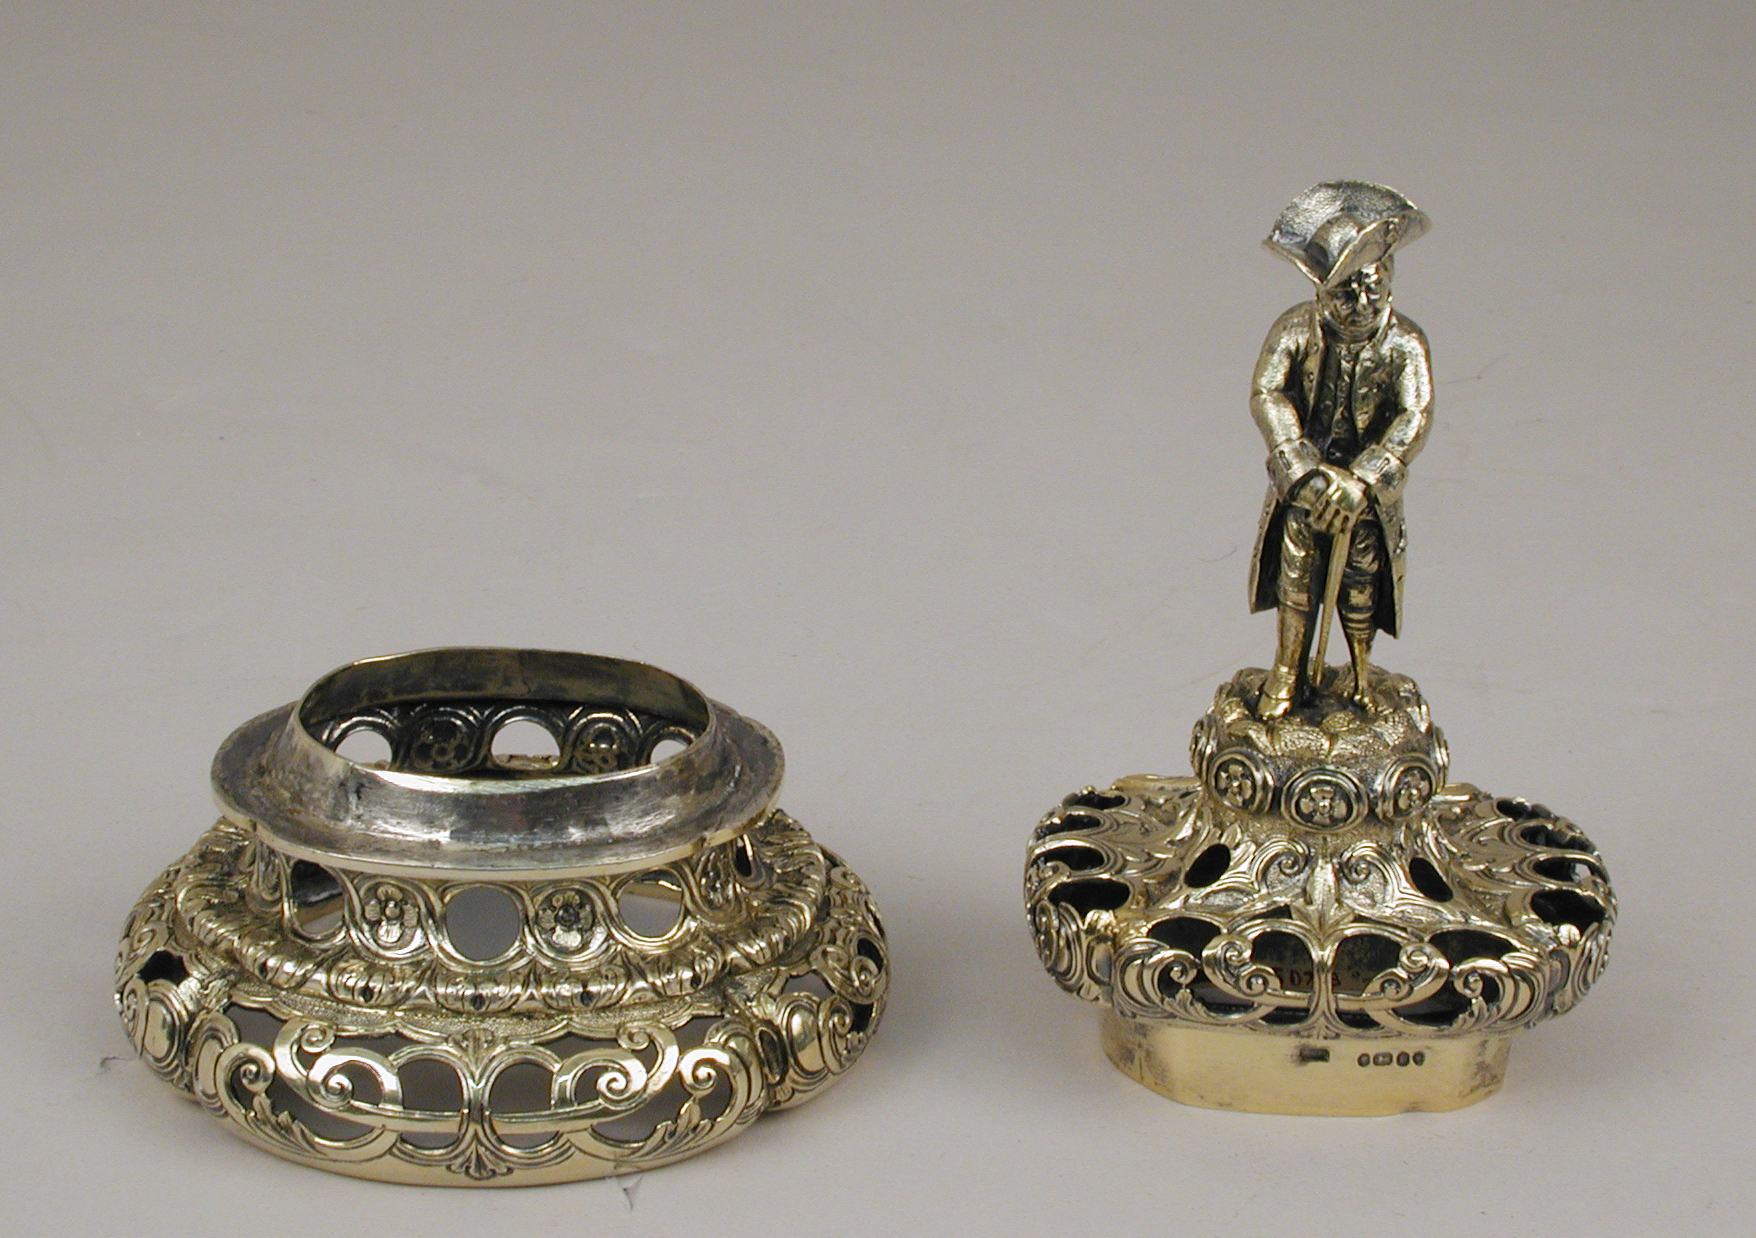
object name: vase mount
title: Vase mounts (one of a pair)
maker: l.h.r., london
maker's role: maker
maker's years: 1850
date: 1850-1851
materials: silver gilt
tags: tricorns,men,flowers